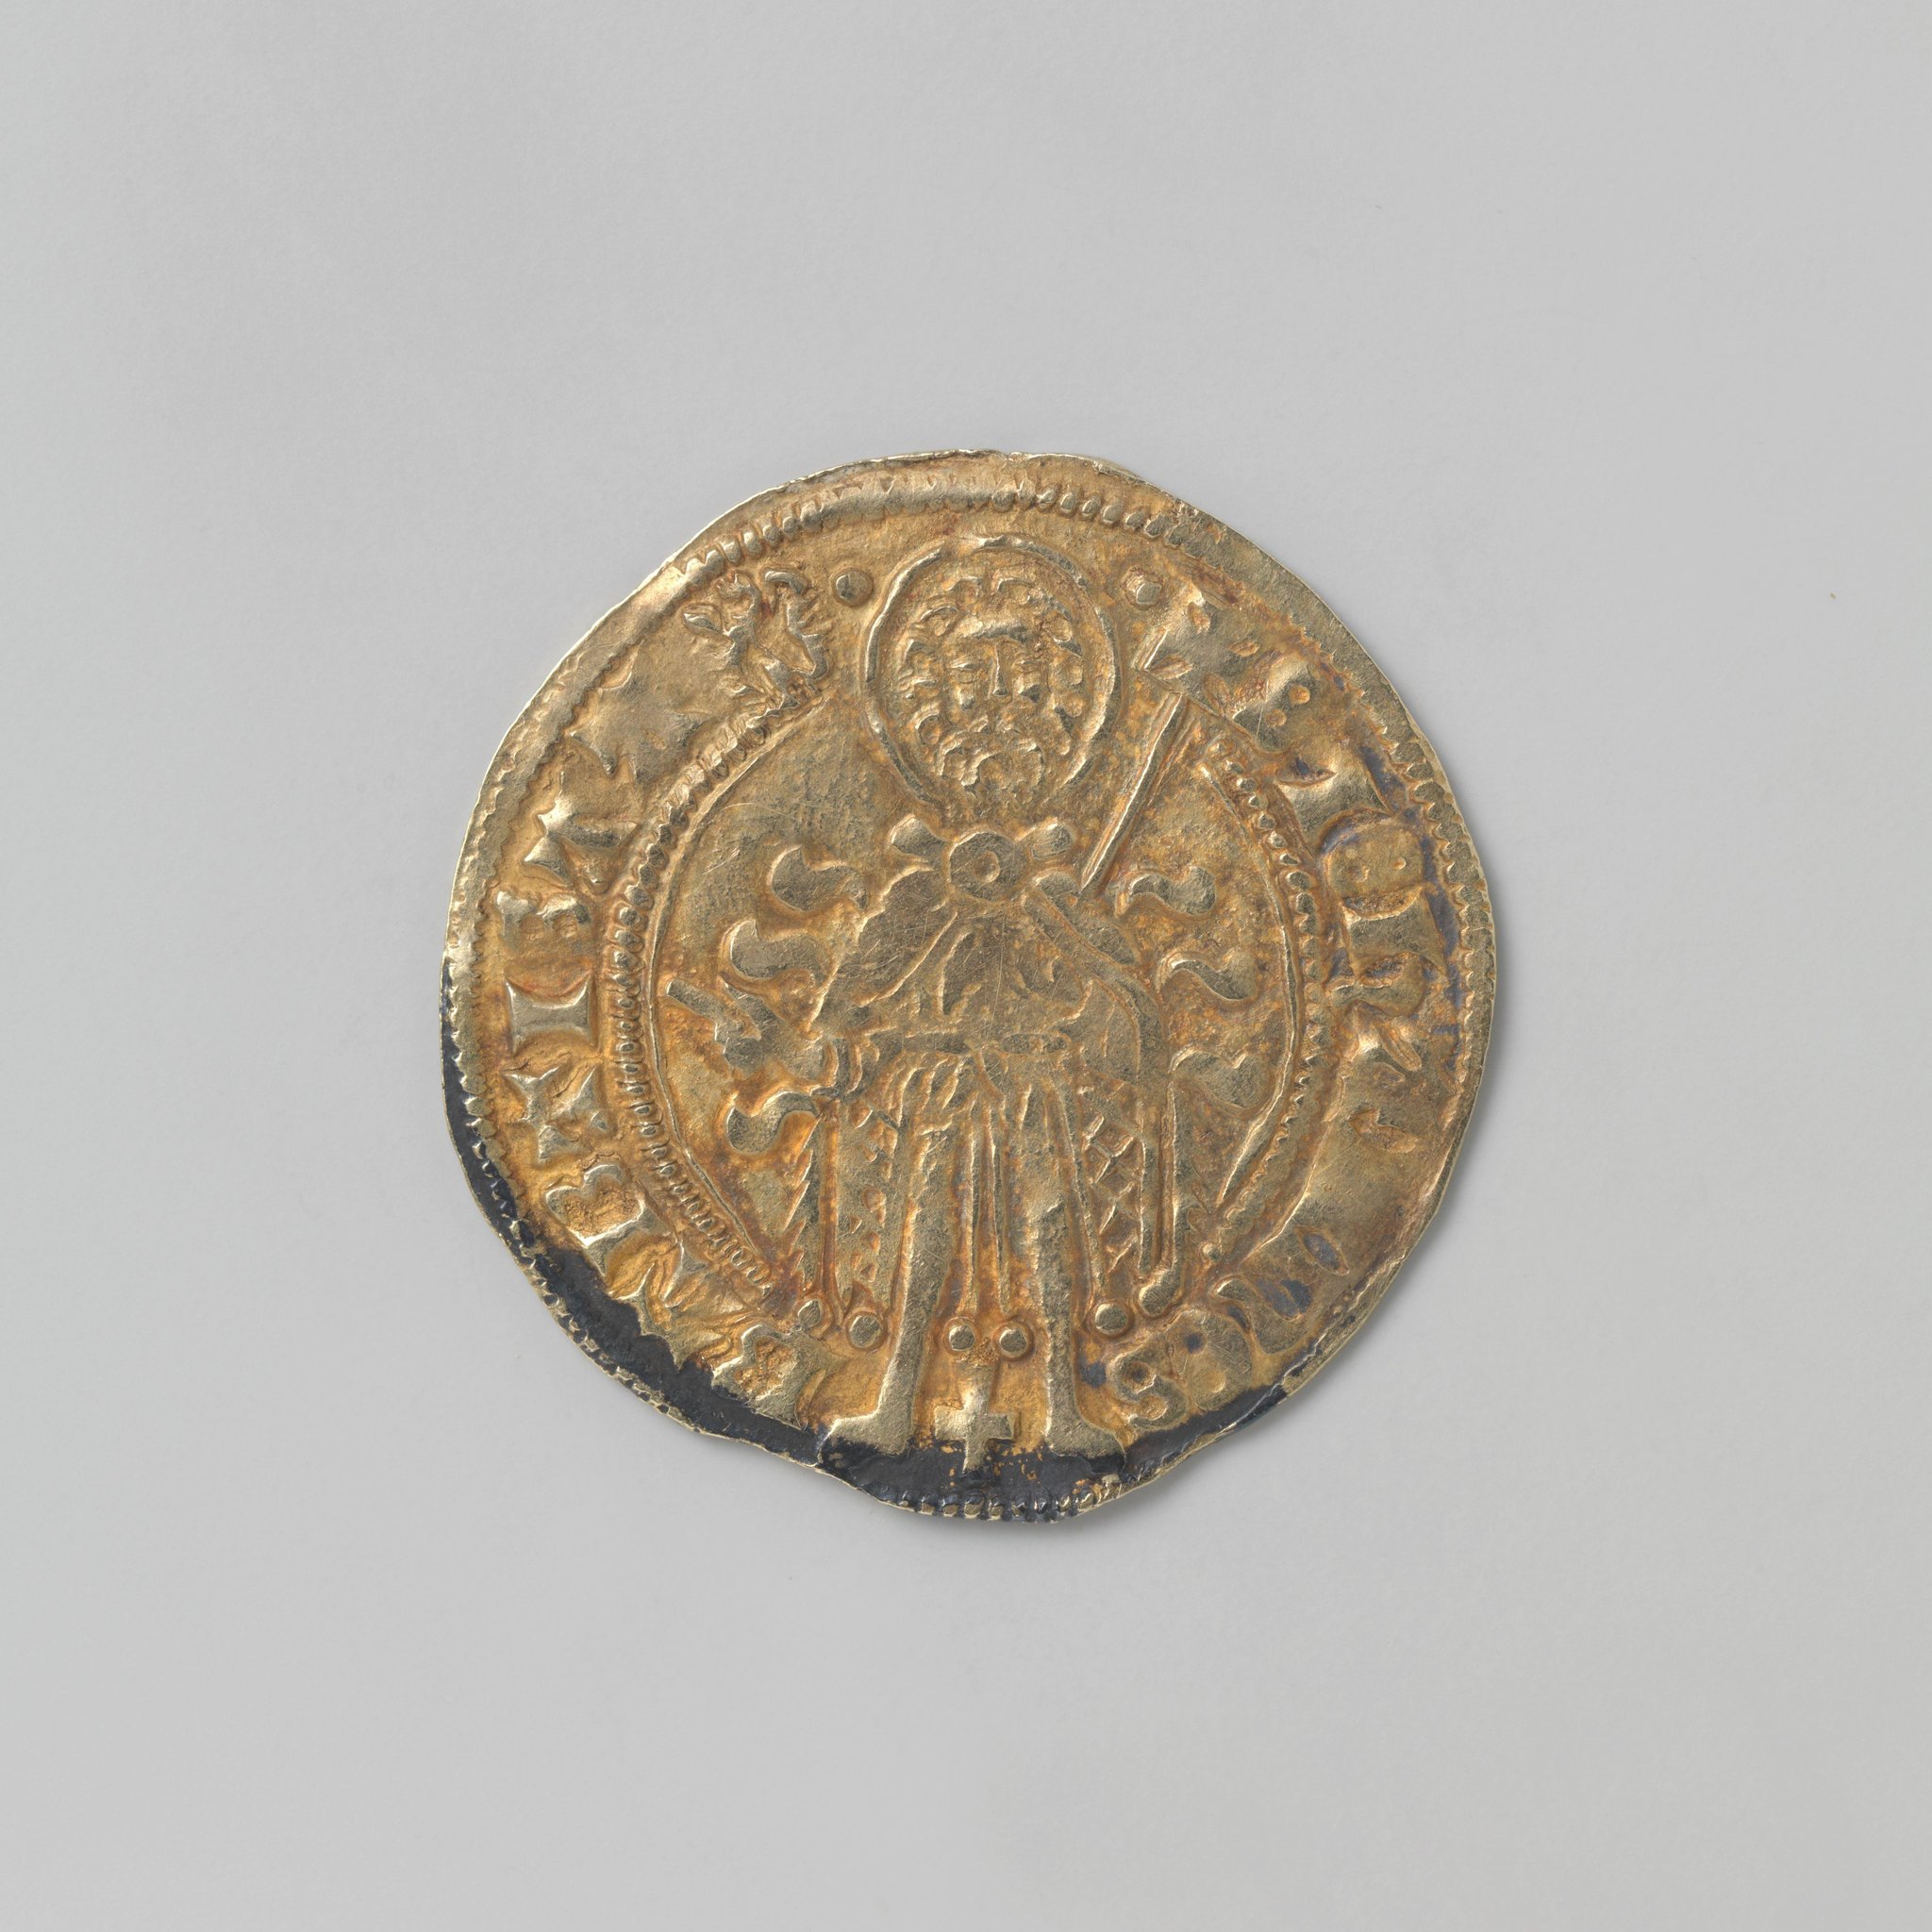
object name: coin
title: Gelderse Sint Jansgulden van hertog Arnold, 1423-1472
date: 1423-1472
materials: gold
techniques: striking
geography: gelderland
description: Gouden munt. Voorzijde: staande heilige, in linkerhand kruisstaf. Omschrift: S IOHANNES-BABTISTA [leeuw]. Keerzijde: in vierpas vijf wapenschildjes.